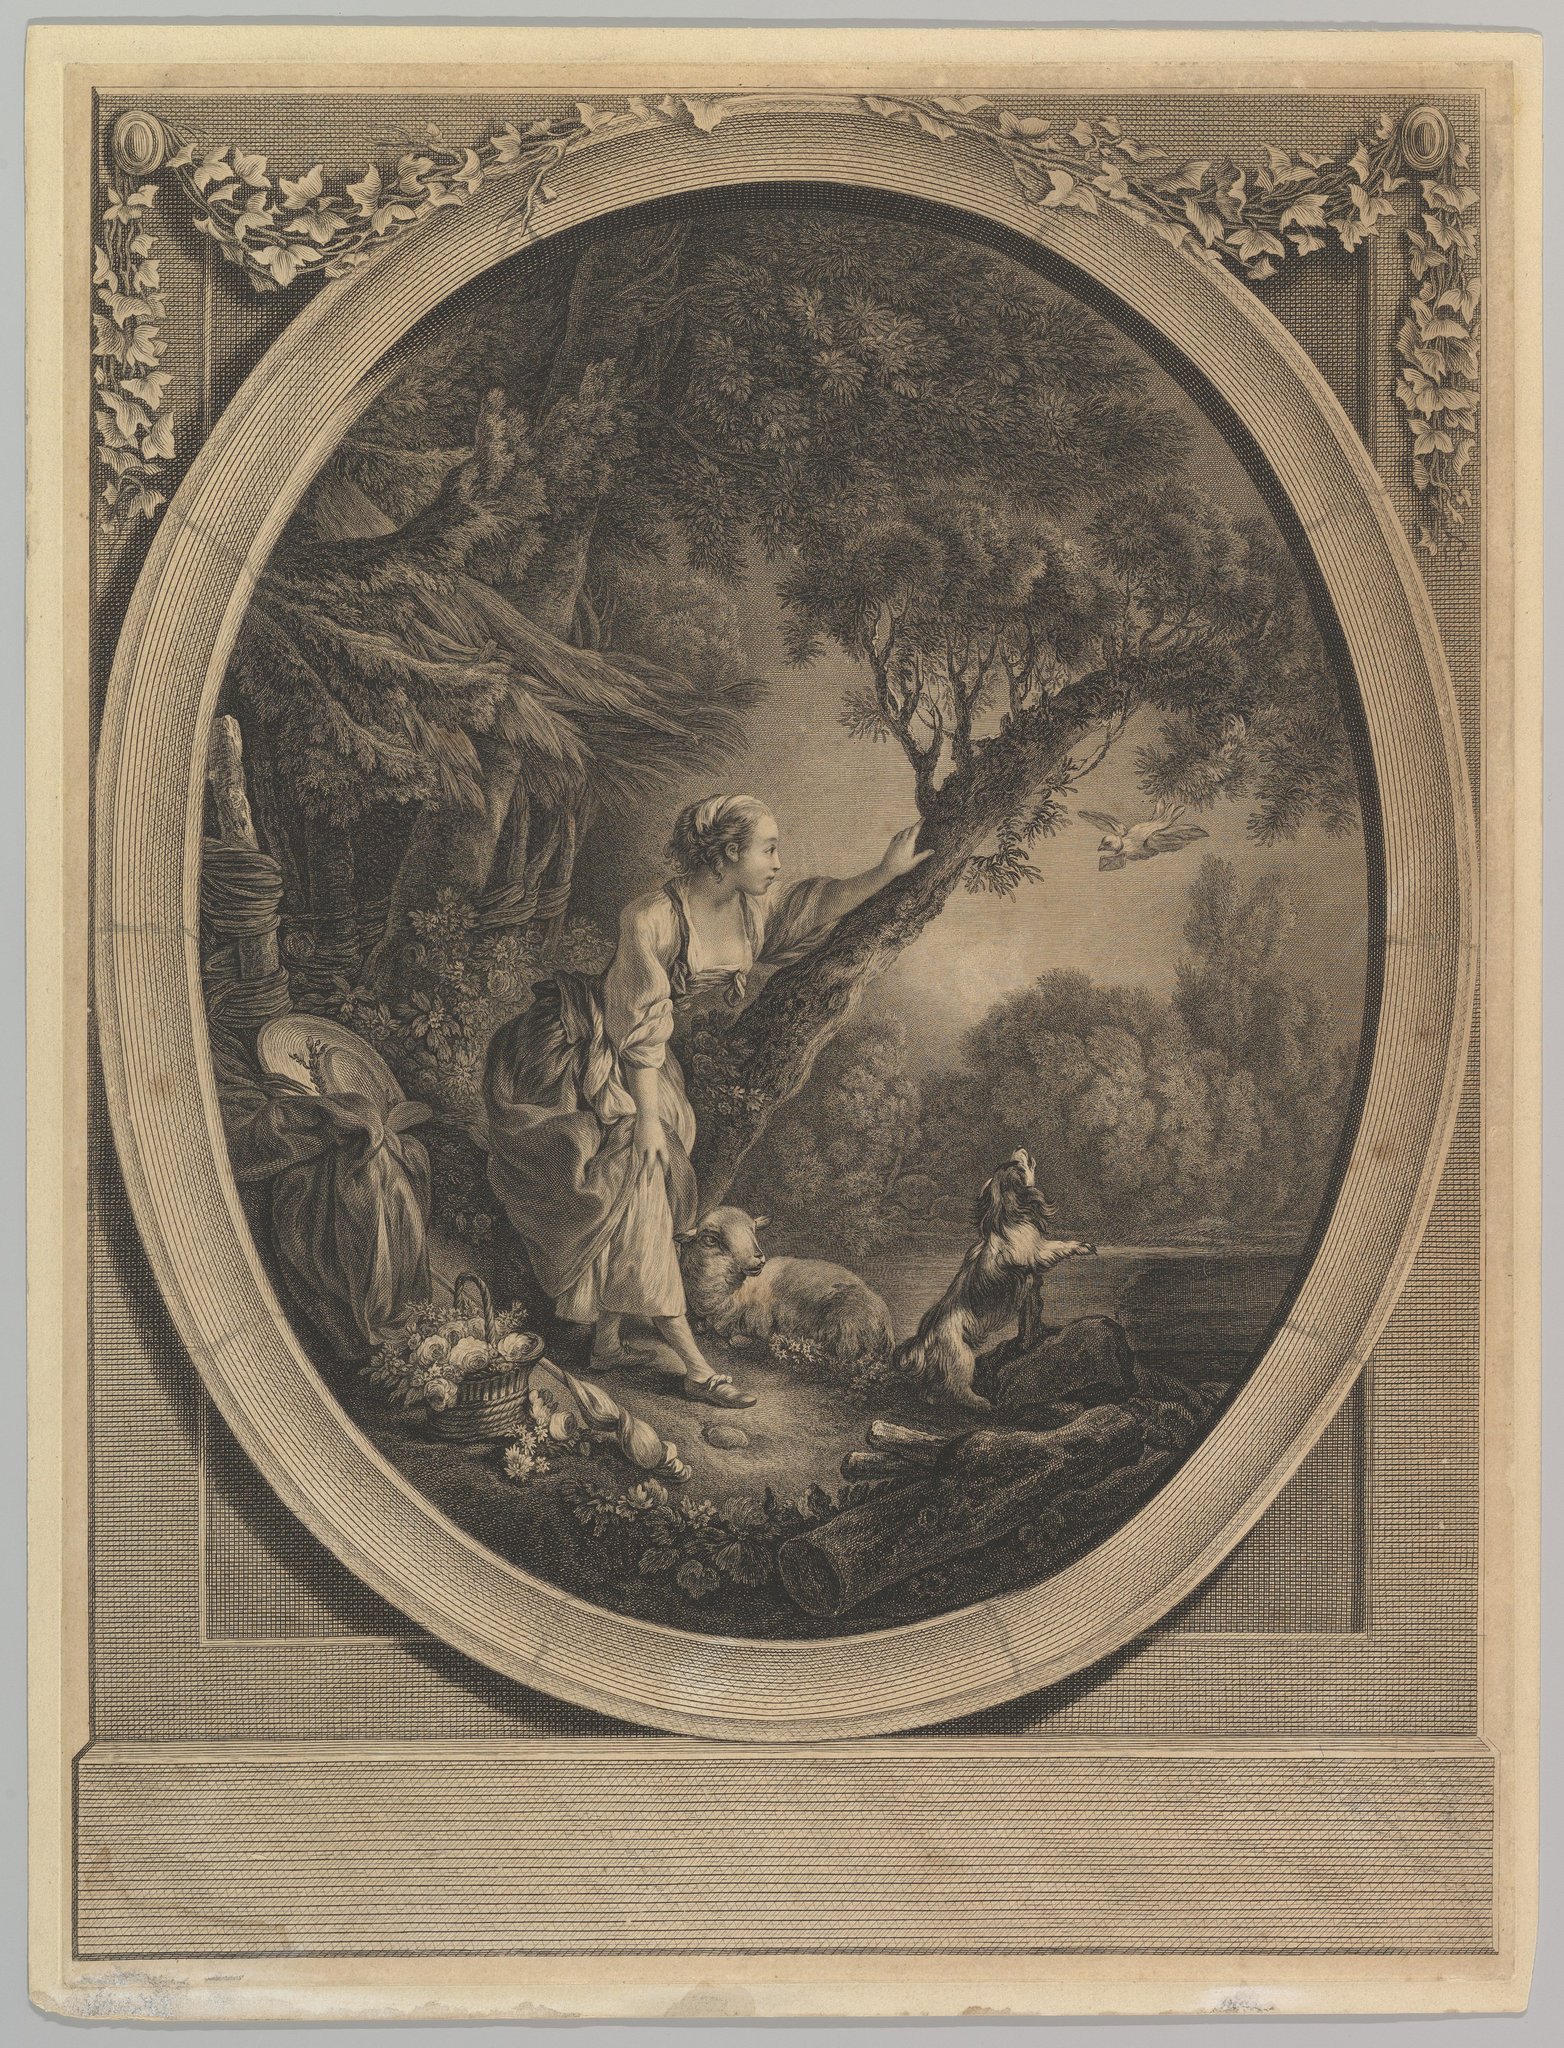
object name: print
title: L'Arrivée du Courier (The Arrival of the Messenger)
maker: jacques firmin beauvarlet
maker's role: artist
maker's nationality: french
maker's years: 1731-1797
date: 1701-1800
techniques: engraving, etching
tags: animals,birds,women,dogs